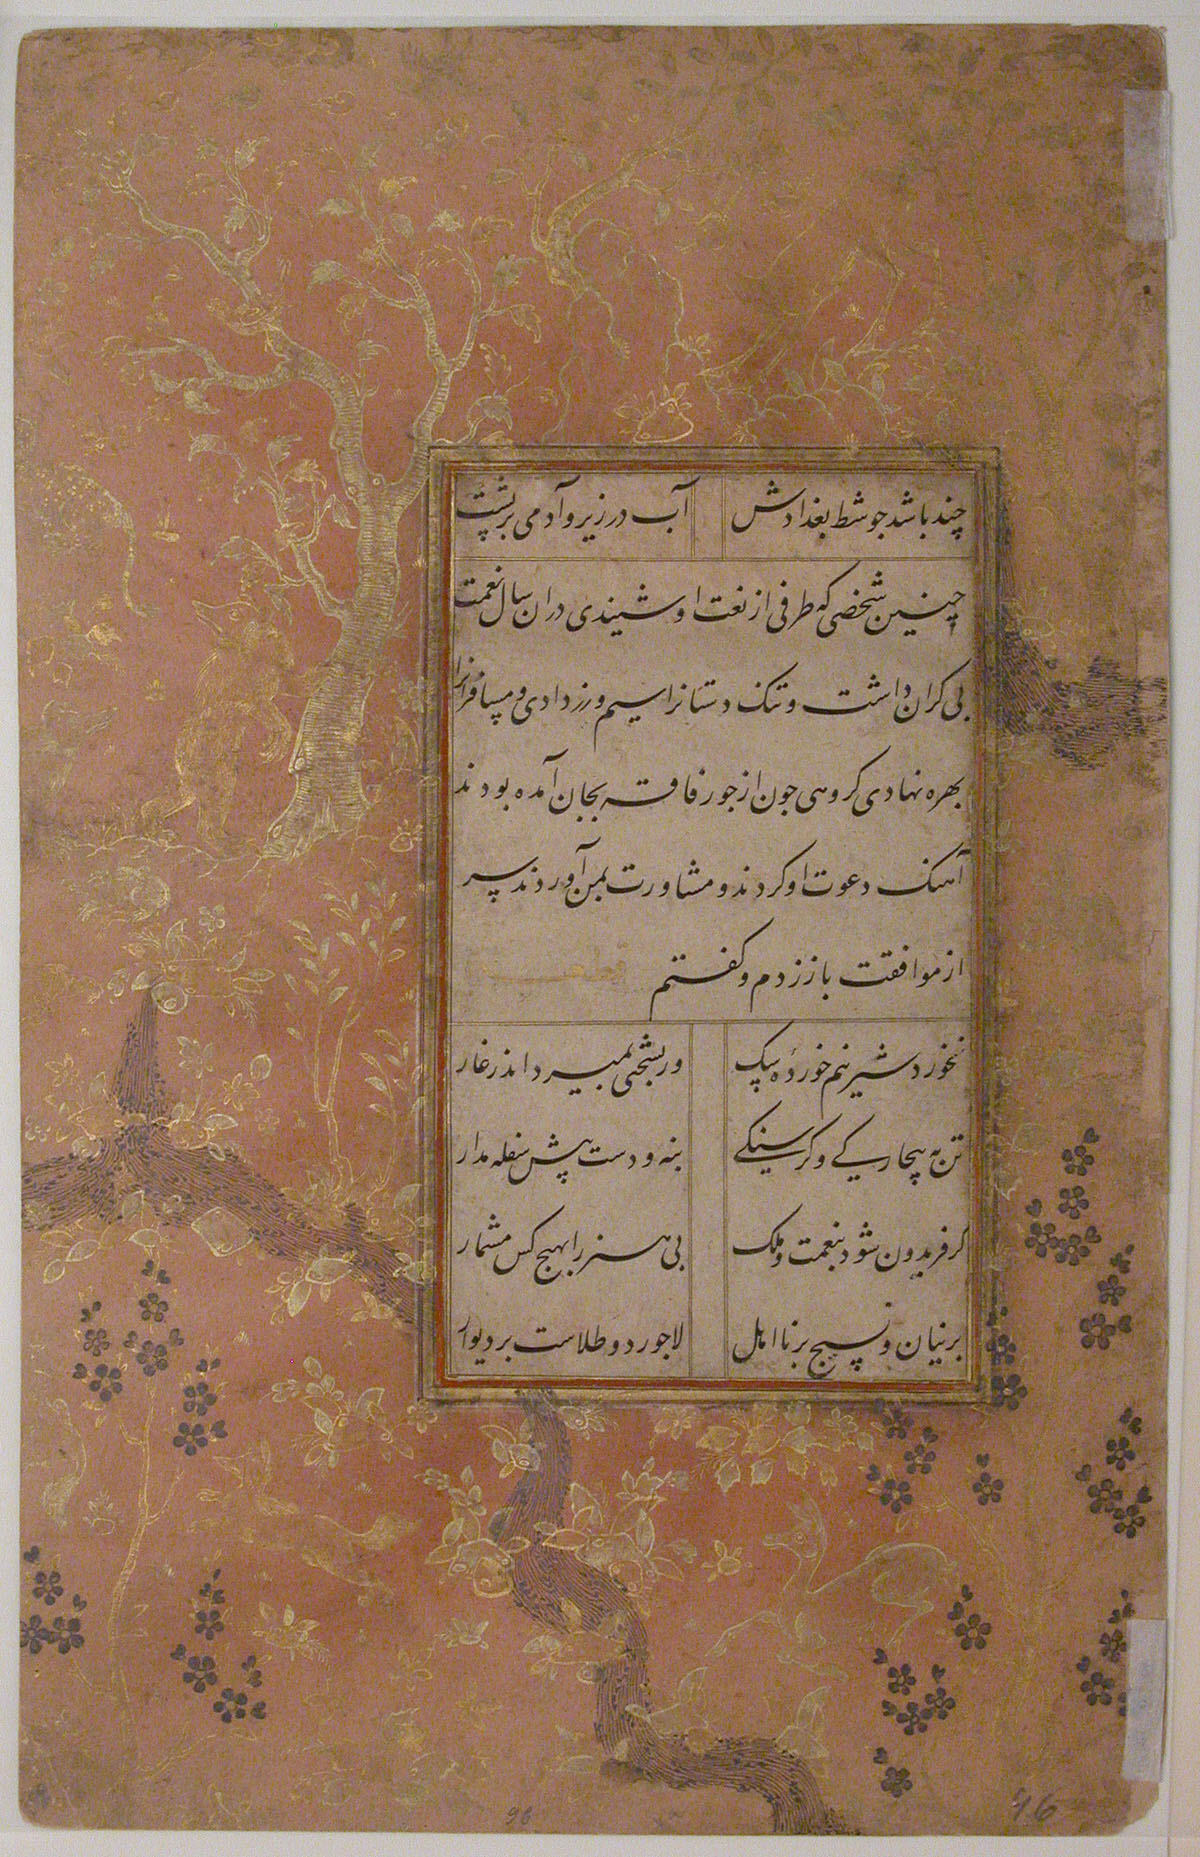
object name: folio from a non illustrated manuscript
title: Page of Calligraphy from an Anthology of Poetry by Sa`di and Hafiz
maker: sa'di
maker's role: author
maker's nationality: iranian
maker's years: 1213-1291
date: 1467-1500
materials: gold, ink, paper, silver, watercolor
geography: afghanistan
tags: animals,poetry,calligraphy